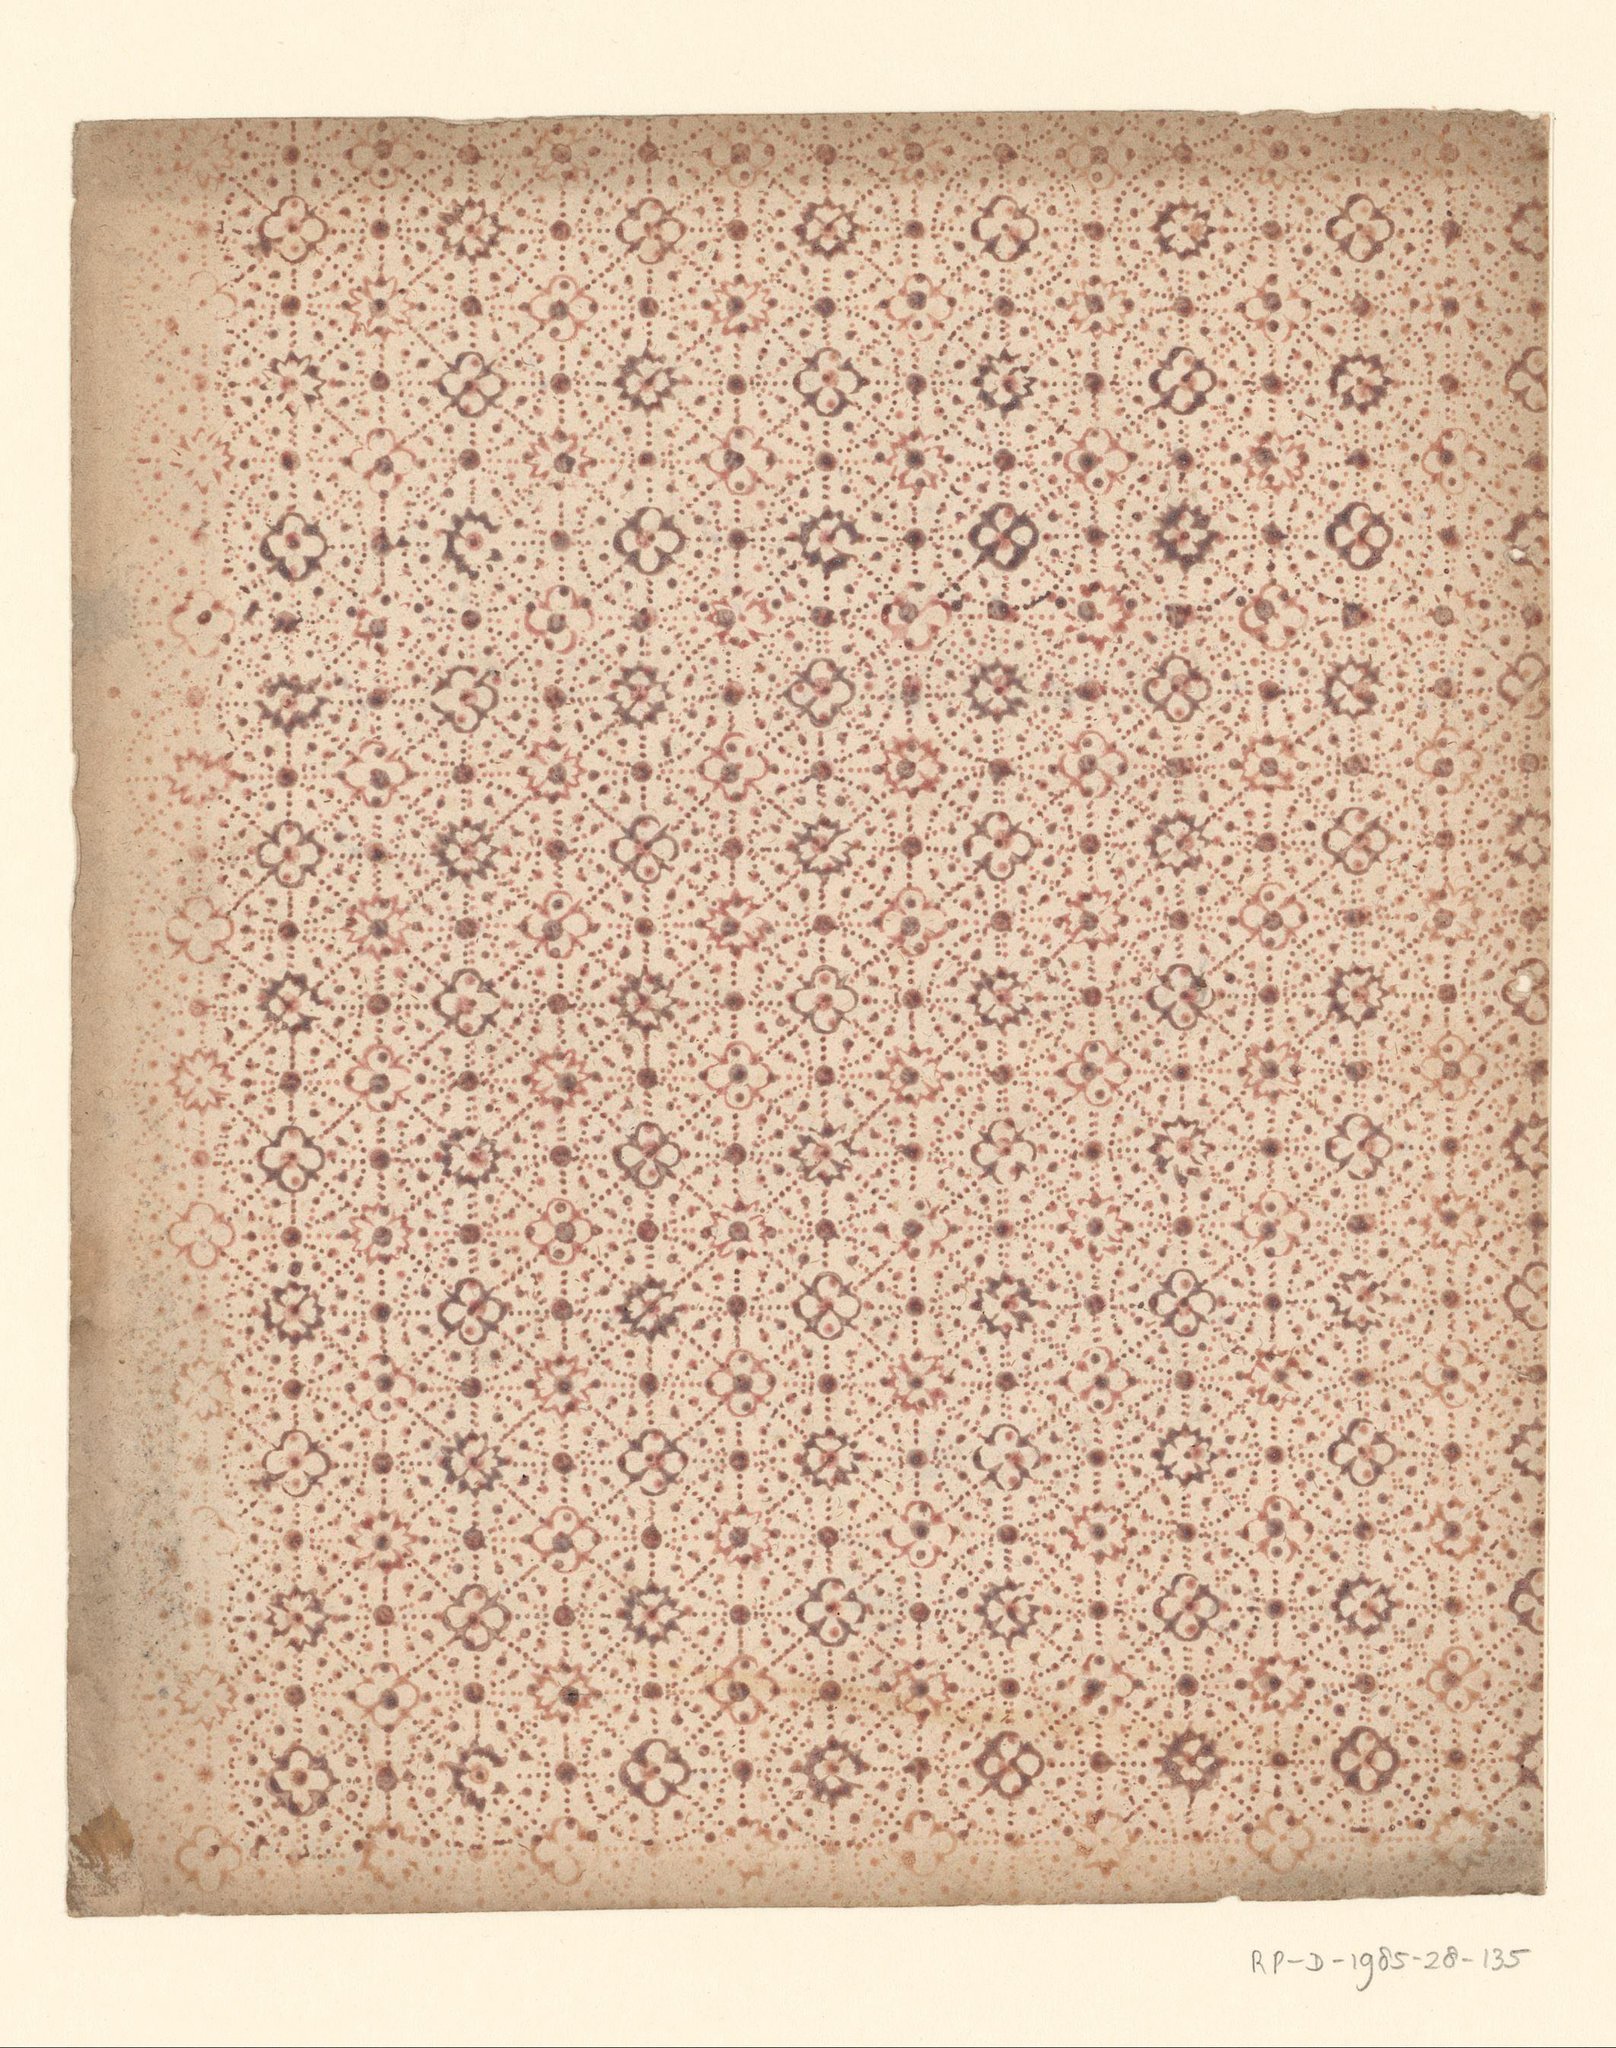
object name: printed paper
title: Blad met banenpatroon van cirkels bestaande uit punten met rozet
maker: Anonymous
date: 1750-1900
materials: paper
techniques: printing block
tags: ornament ~ geometric motifs, ornament derived from plant forms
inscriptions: collector's mark: Lugt 2760, collector's mark: Lugt 2228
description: Blad met banenpatroon van cirkels bestaande uit punten met rozet en diagonale stippellijnen. Helft van een omslag.